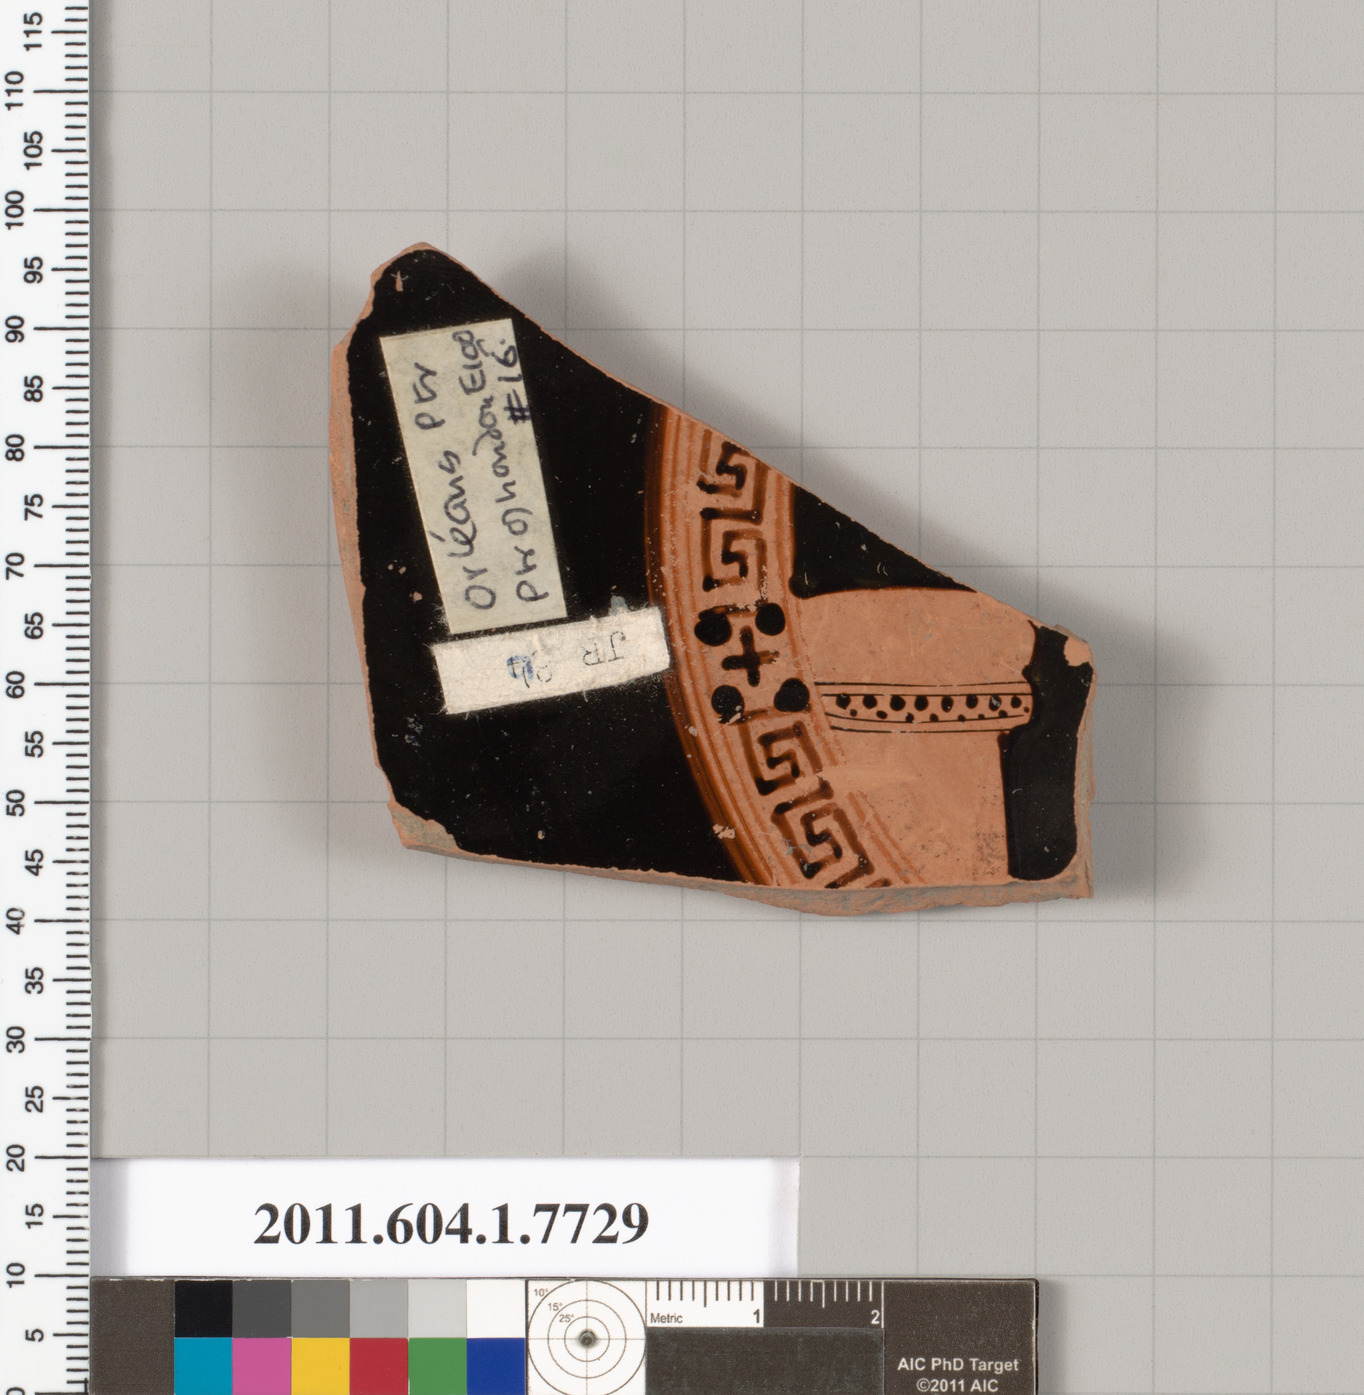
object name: kylix fragment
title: Terracotta fragment of a kylix (drinking cup)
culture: greek, attic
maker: orleans painter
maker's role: artist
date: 480-460 BCE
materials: terracotta